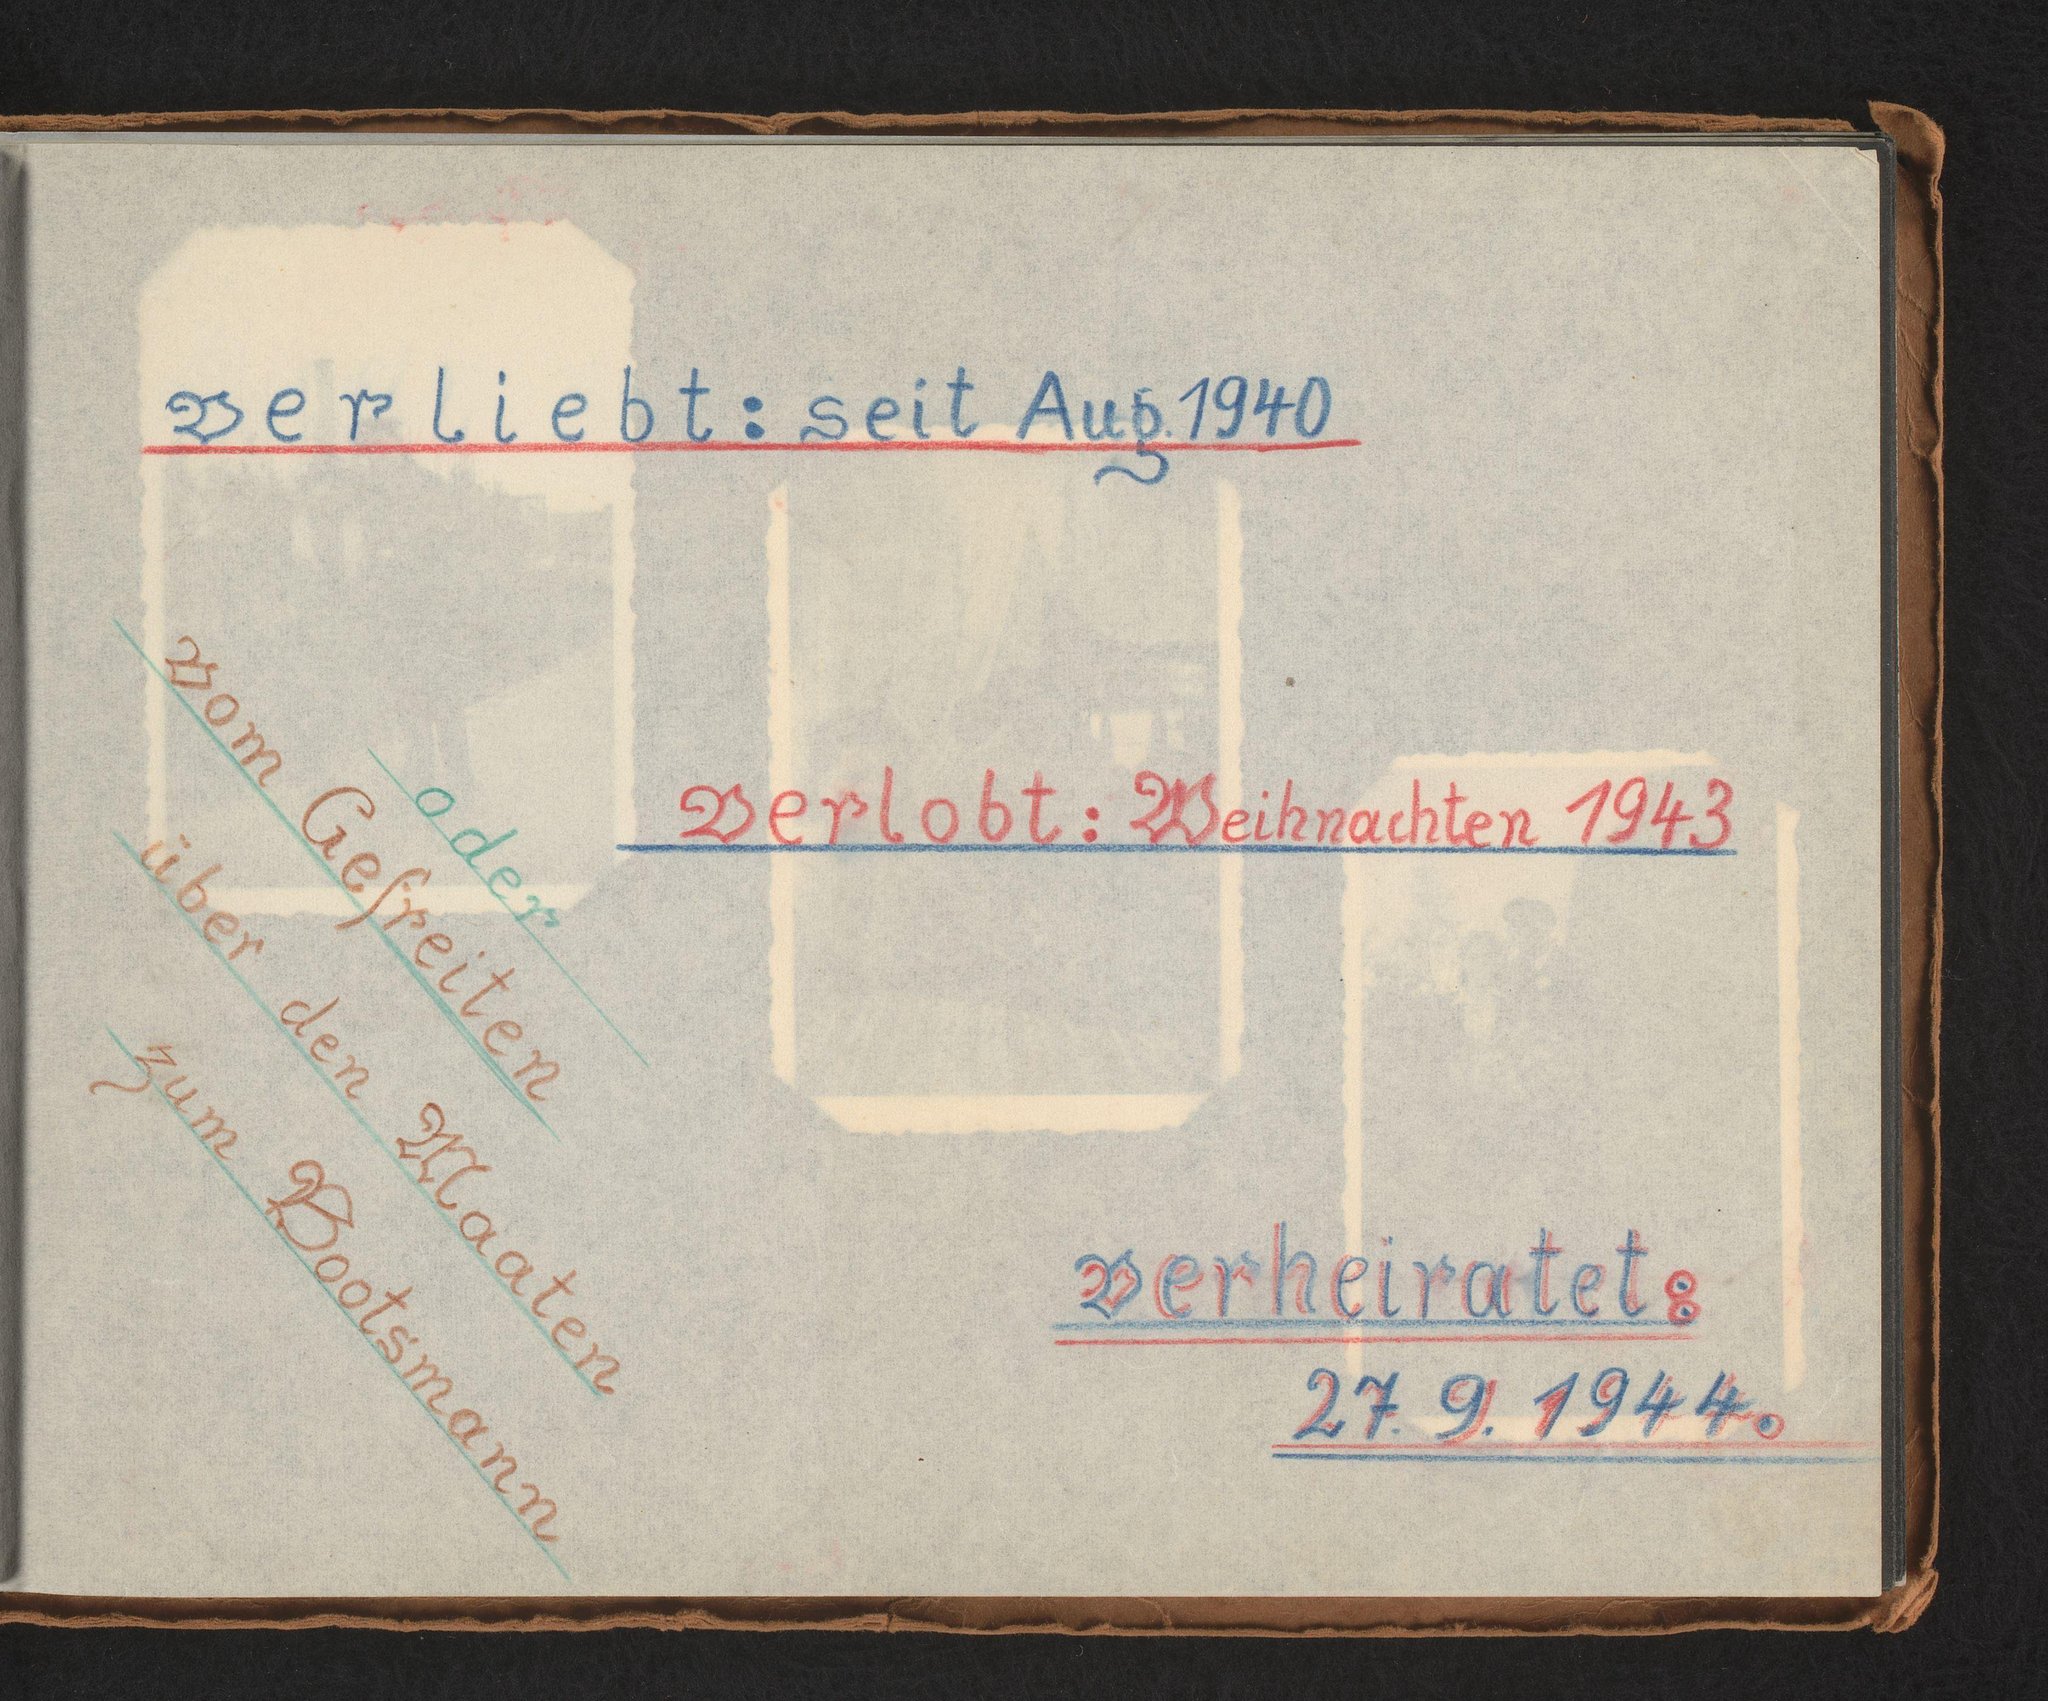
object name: album leaf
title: Verliefd, verloofd en gehuwd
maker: werner neufang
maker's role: militair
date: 1944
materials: paper, pencil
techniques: writing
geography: germany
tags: kriegsmarine, tweede wereldoorlog, bezetting van nederland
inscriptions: date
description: Blad met tekst en data van de verliefdheid, verloving en huwelijk van Werner en Thea, 1940-1944. Waarschijnlijk ter gelegenheid van het huwelijk op 27 september 1944. Tussenblad tussen bladzijde 6 en 7. Onderdeel van een fotoalbum over de Duitse Werner Neufang van de Kriegsmarine en de Nederlandse Thea Driesen.